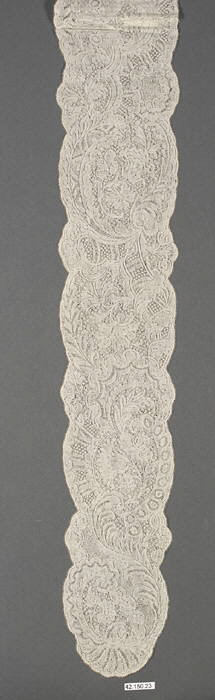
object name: lappet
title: Lappets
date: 1701-1733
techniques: lace